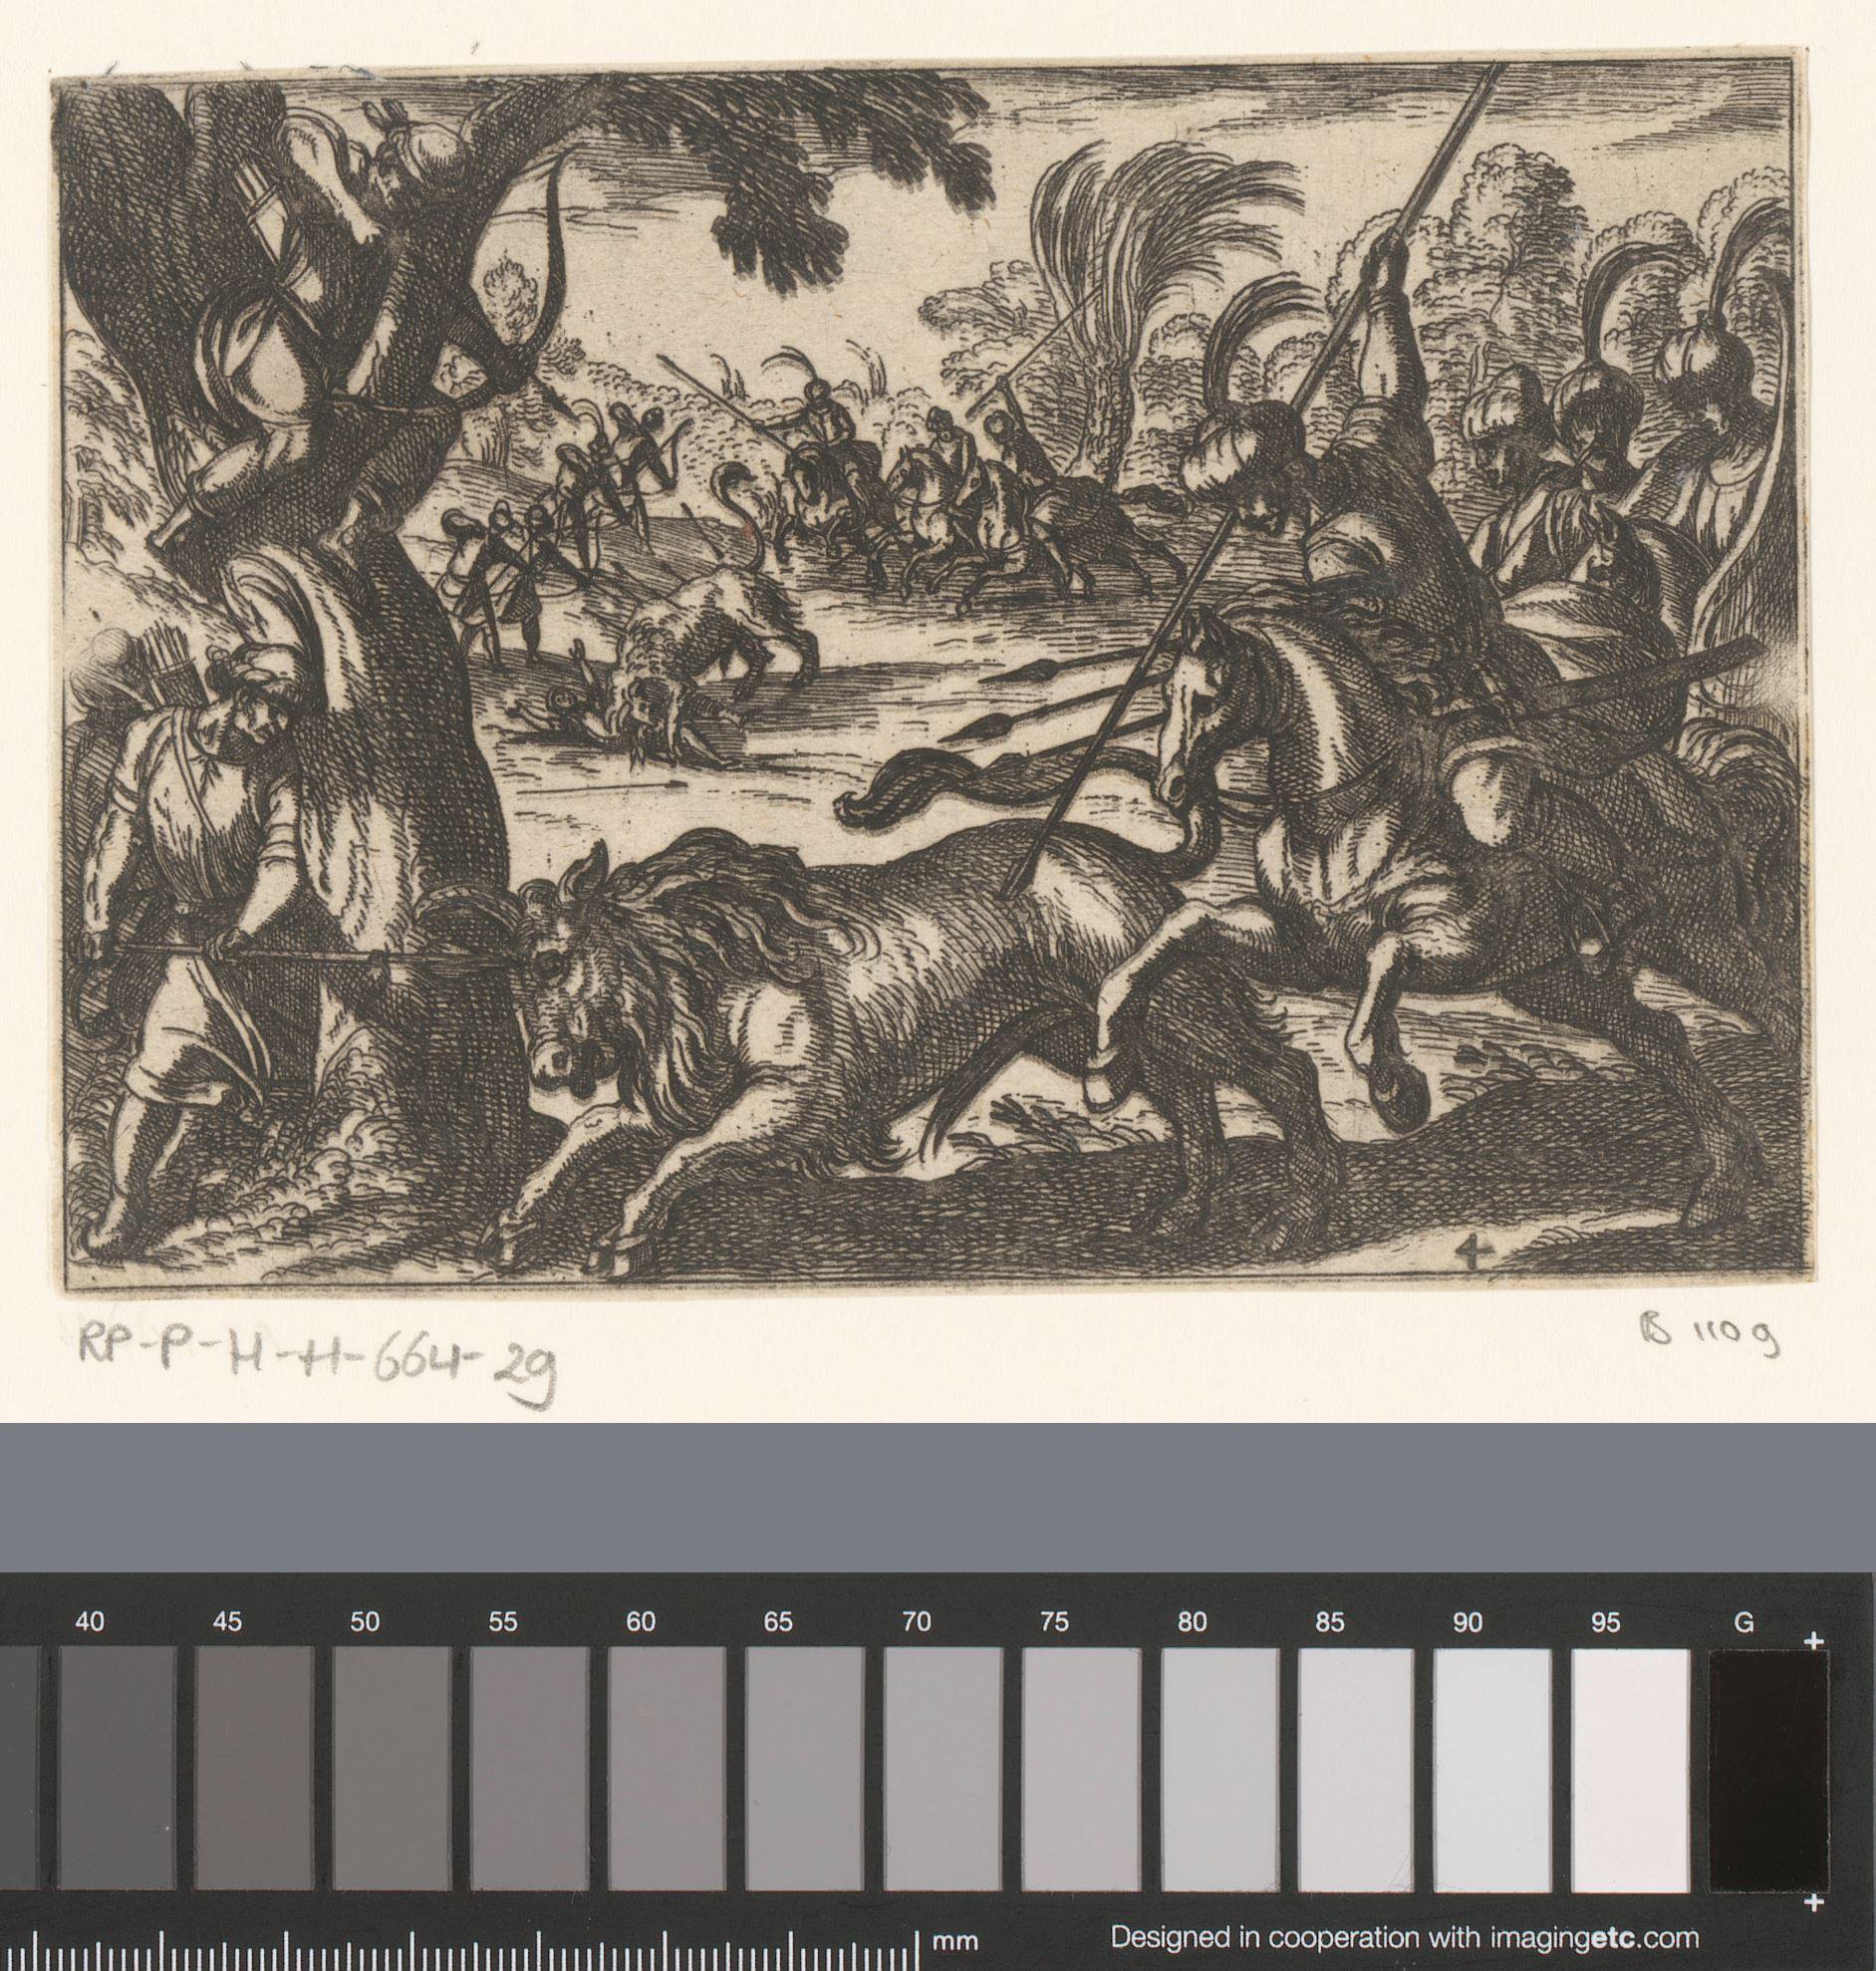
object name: print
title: Jachtscènes (deel 3)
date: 1598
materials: paper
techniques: etching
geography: rome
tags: hunter, hunters hunting (n.b.: in 1988-1990 this notation denoted the concept of 43c11421 'hunters resting during the hunt'), hoofed animals: bison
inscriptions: collector's mark: ‘Hinloopen’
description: Deze prent maakt deel uit van een reeks van vijftien prenten met jachtscènes (+ opdracht).